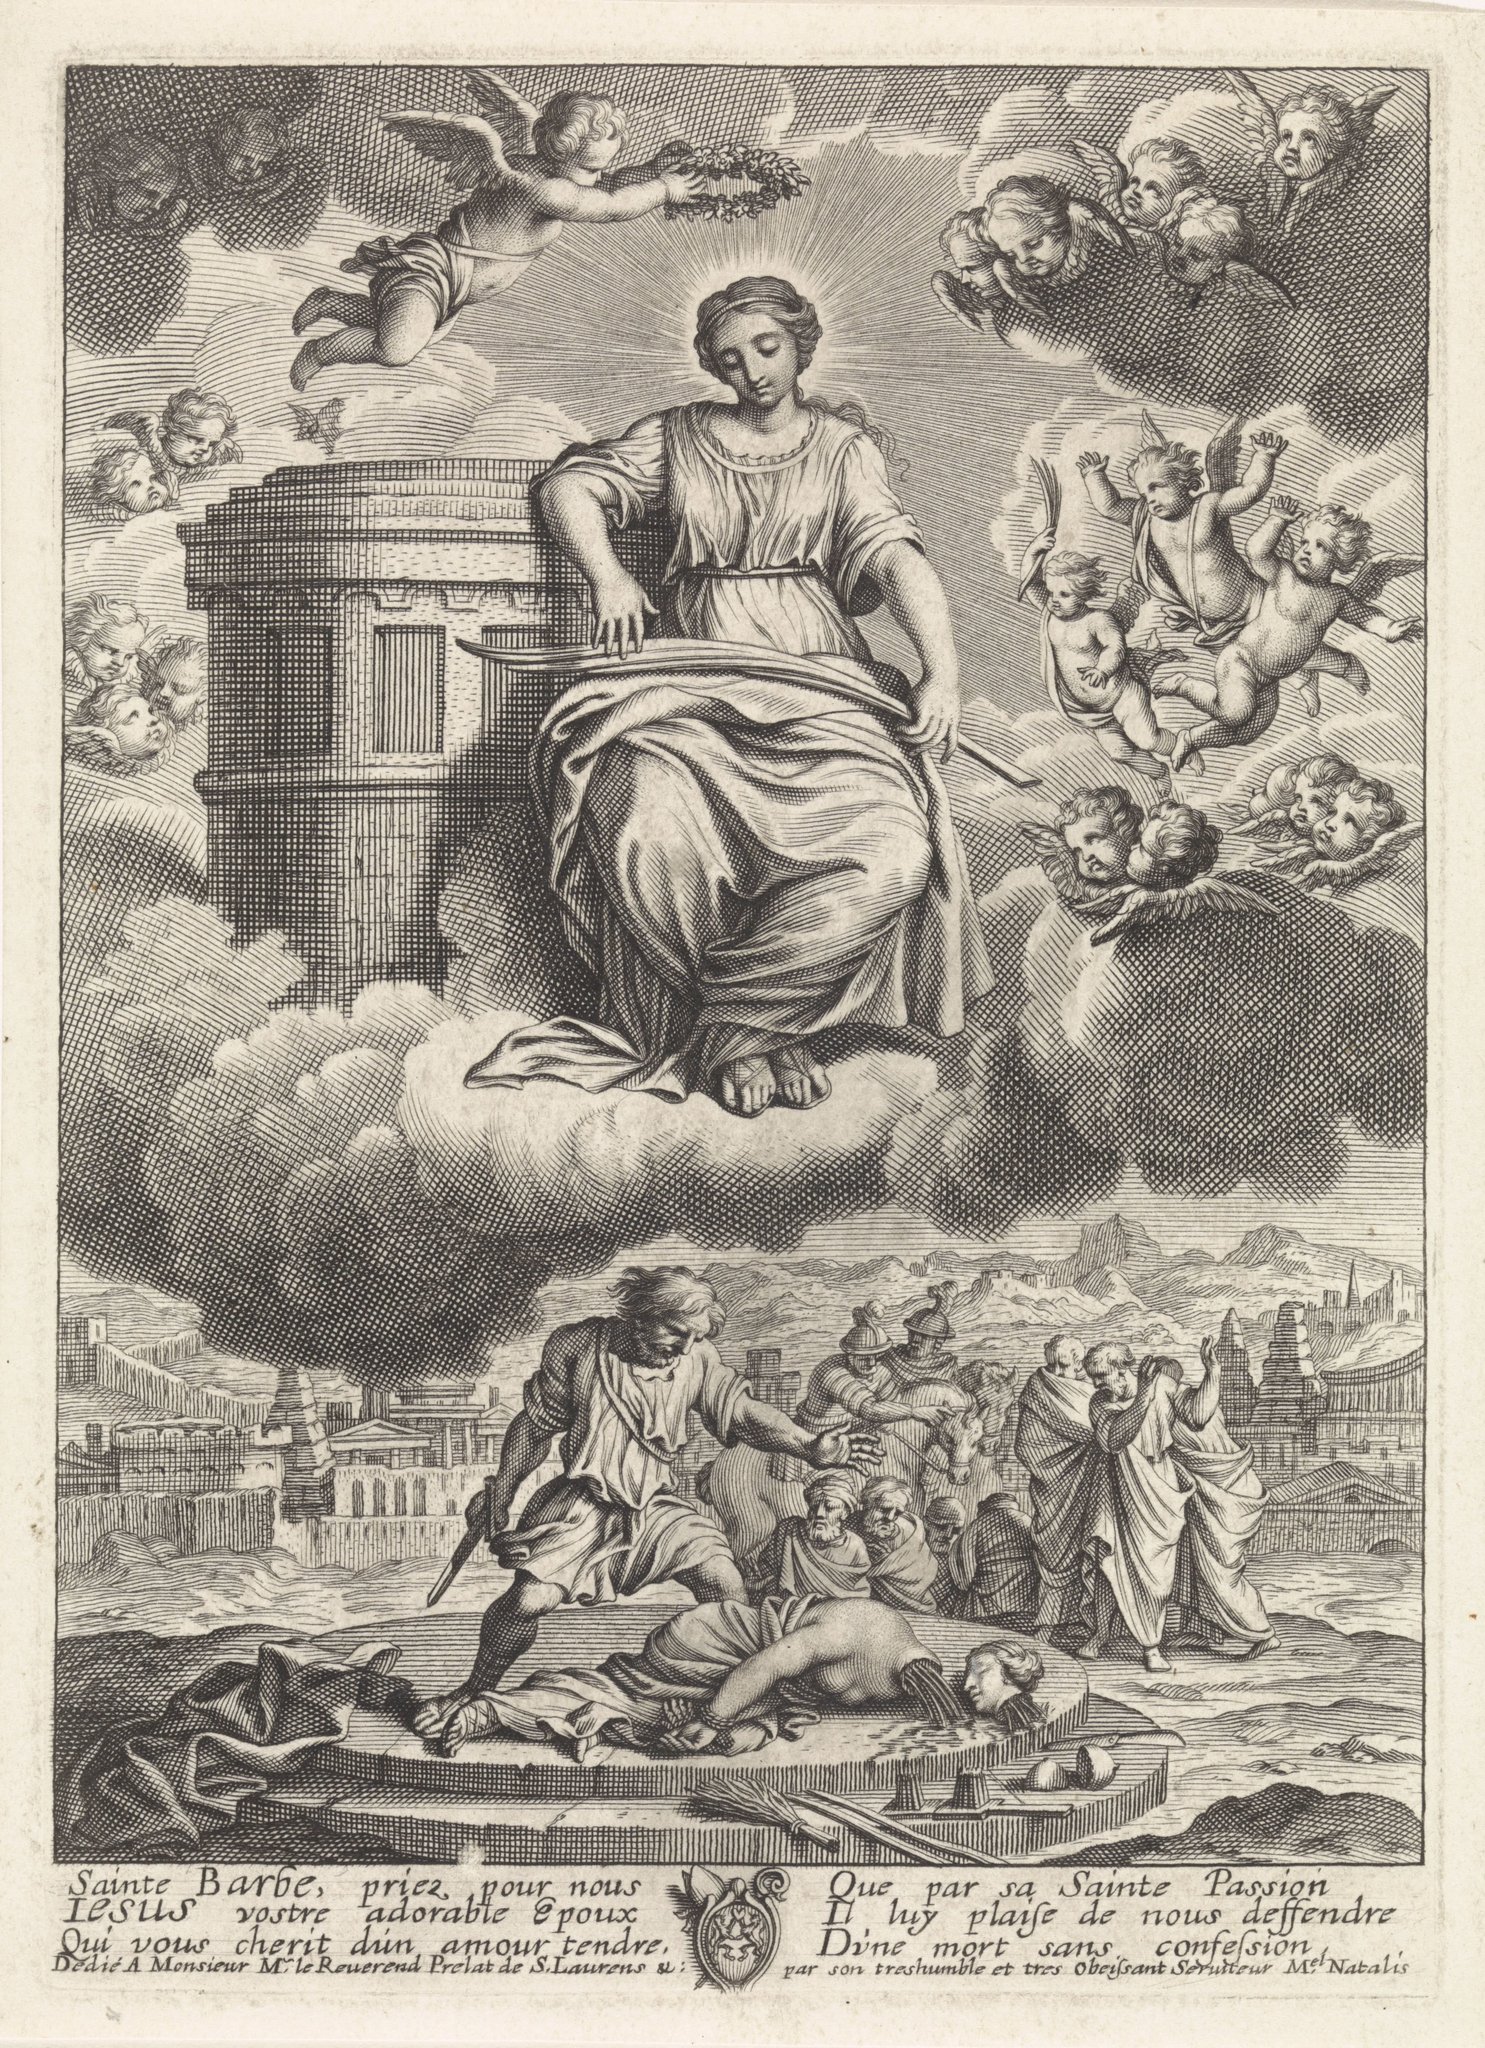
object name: print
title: Dood van de heilige Barbara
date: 1620-1668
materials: paper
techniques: engraving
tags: the virgin martyr barbara; possible attributes: book, cannon(ball), crown, cross, chalice with wafer, dioscuros (her father), peacock feather, sword, torches, mason's tools, tower - apotheosis, glory, triumph of female saint, st. barbara is beheaded by her father dioscuros, who usually wears a turban and brandishes a scimitar (sword); sometimes dioscuros is struck by lightning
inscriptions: collector's mark: Lugt 2228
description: De heilige Barbara ligt onthoofd op de grond. Zij is gedood door haar vader Dioscuros, die naast haar staat met zijn zwaard. Een aantal mannen en twee soldaten te paard kijken toe. Op de achtergrond een stad in een landschap. Bovenaan troont Barbara op de wolken, een palmtak op haar schoot, de toren met drie ramen naast haar. In de lucht cherubijnen en putti. Barbara wordt door een putto van hen gekroond met een krans. Onderaan in de marge een zesregelig gebed in het Frans. Middenonder het wapenschild van Guillaume Natalis, abt van de abdij van Sint Laurent.